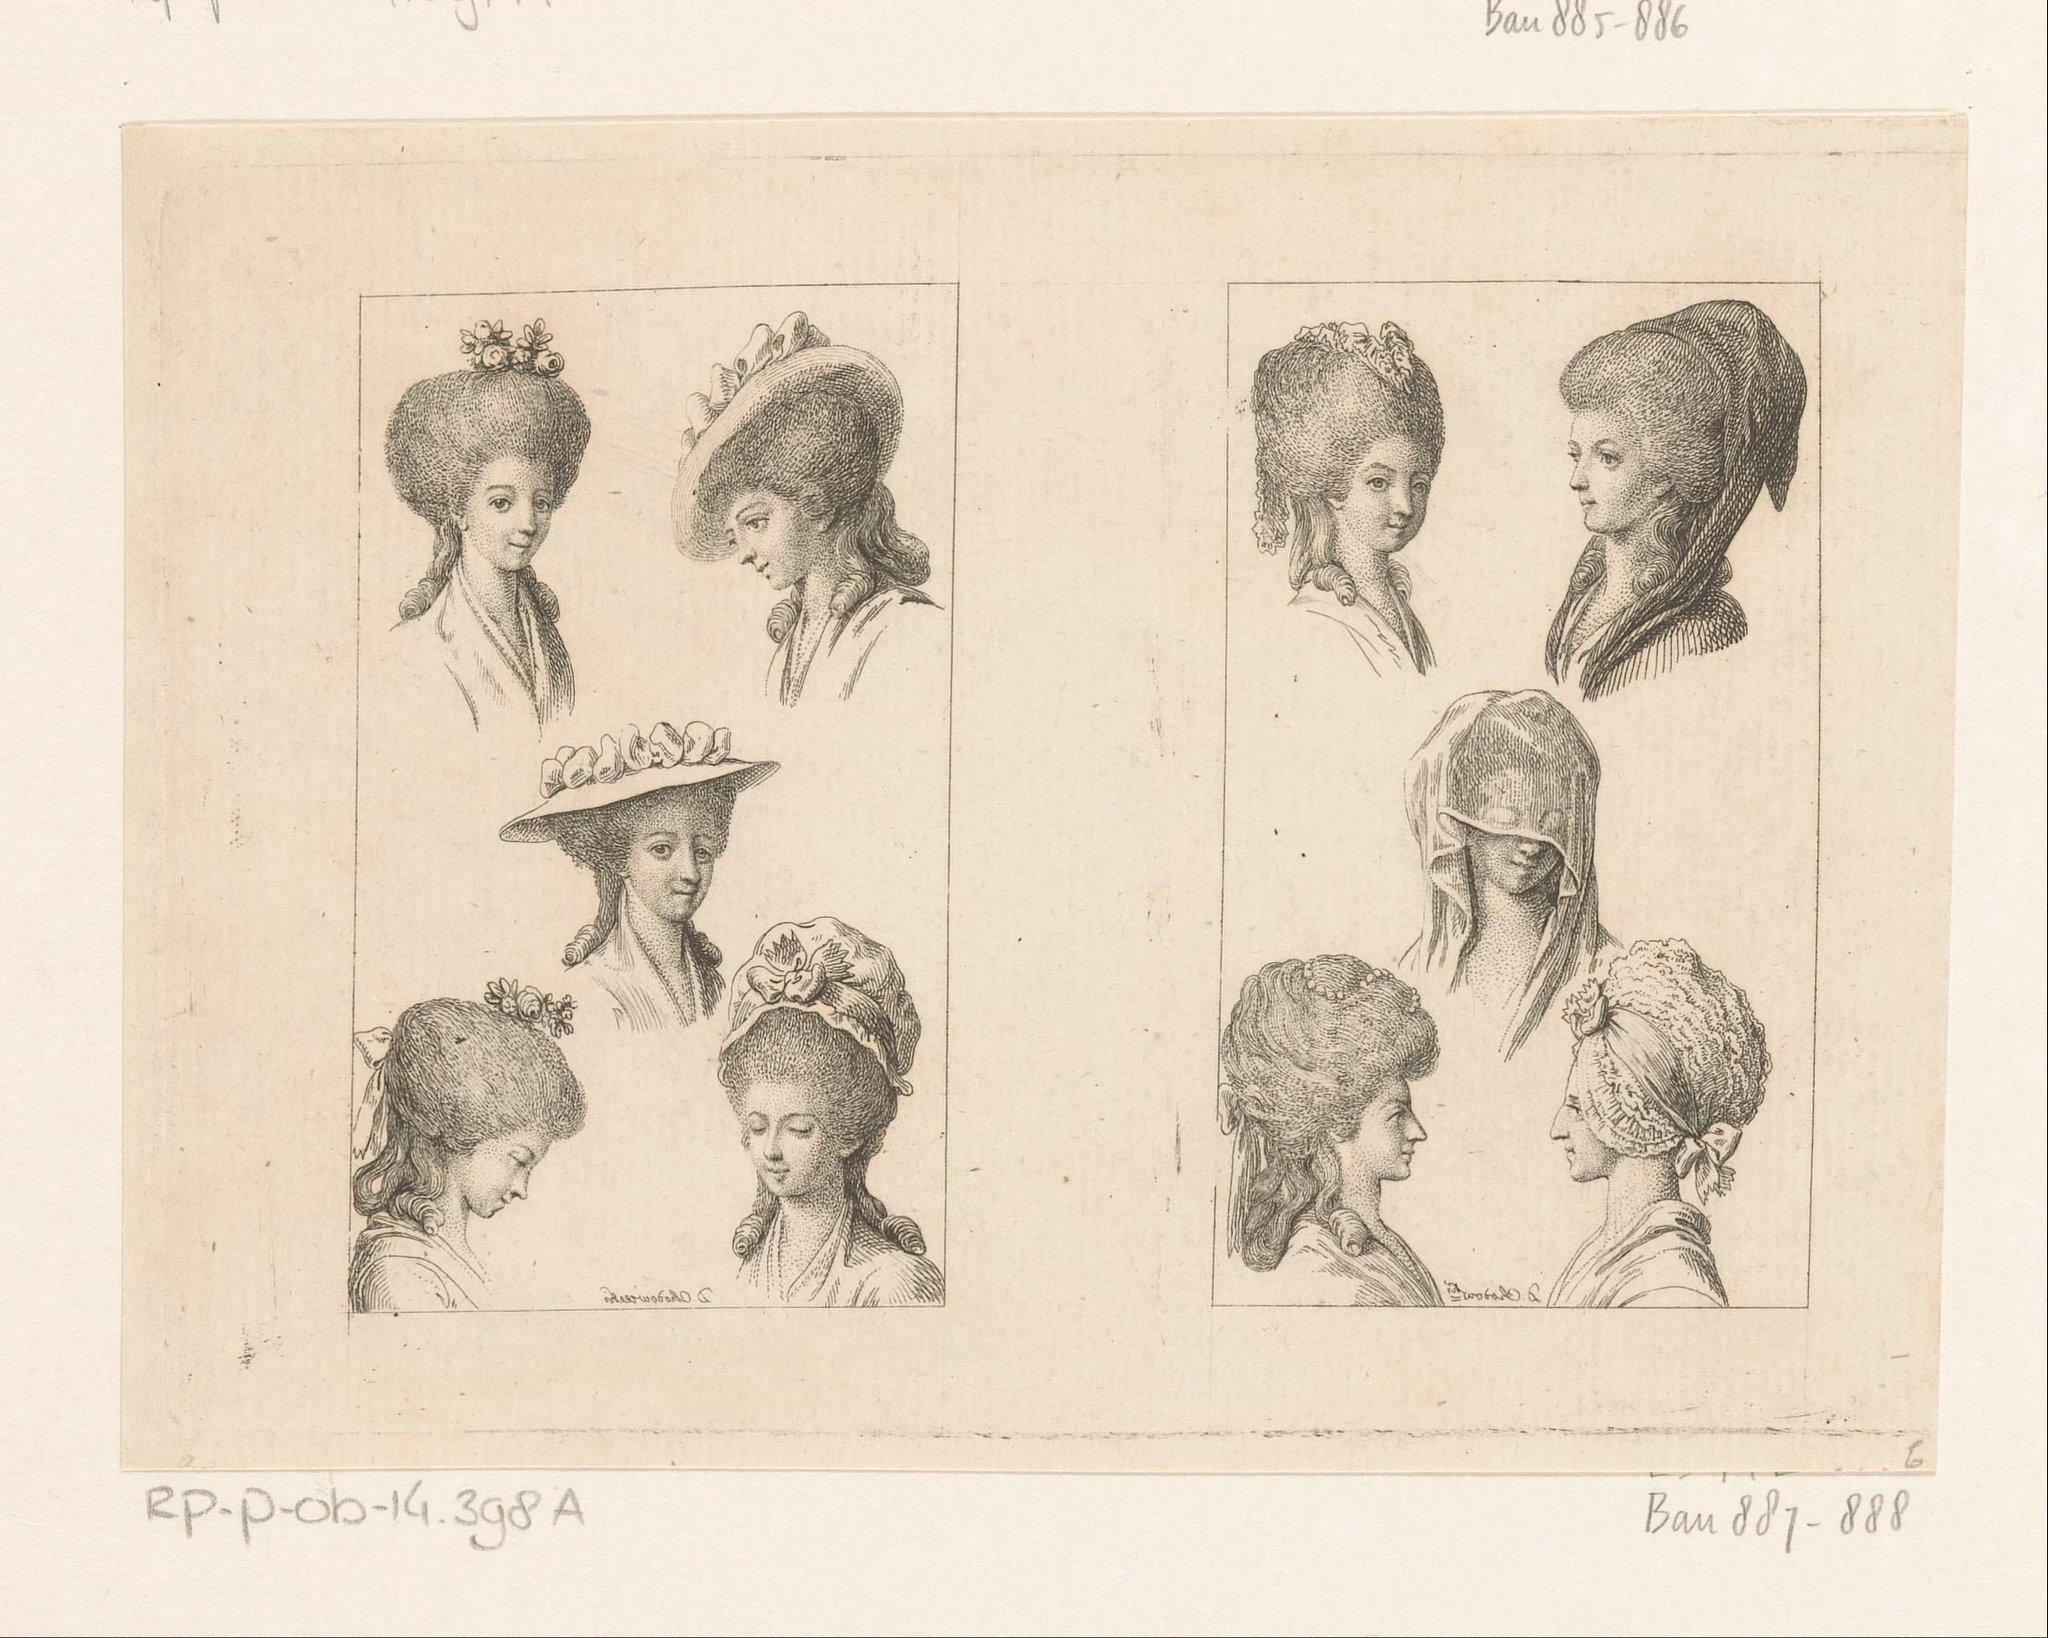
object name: print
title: Twee voorstellingen met kapsels en hoofddeksels voor dames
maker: daniel nikolaus chodowiecki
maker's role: draughtsman, print maker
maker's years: 1726-1801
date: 1782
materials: paper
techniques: etching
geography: berlin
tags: styles of hairdress, head (human) - aa - female human figure (+ front view), fashion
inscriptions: collector's mark: Lugt 2228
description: Prent gebruikt voor: Köningl. Grosbr. Genealogischer Kalender auf das 1783 Jahr. Lauenburg: J. G. Berenberg, 1782.